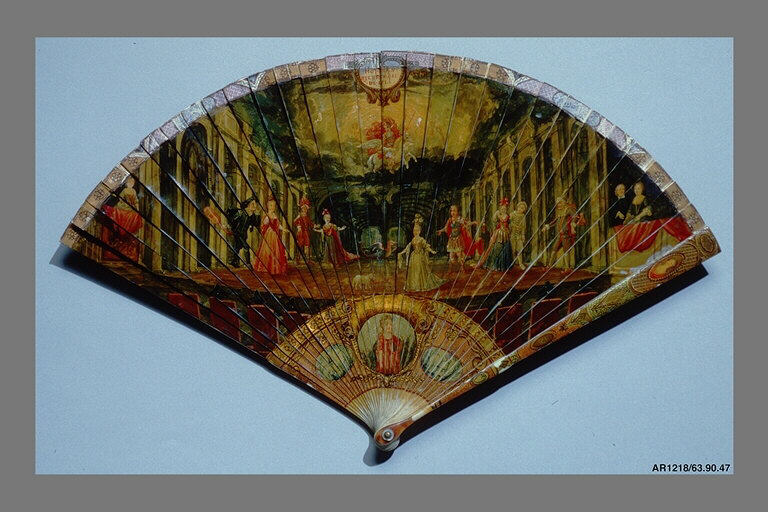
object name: fan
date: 1701-1800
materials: ivory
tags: performance,men,women